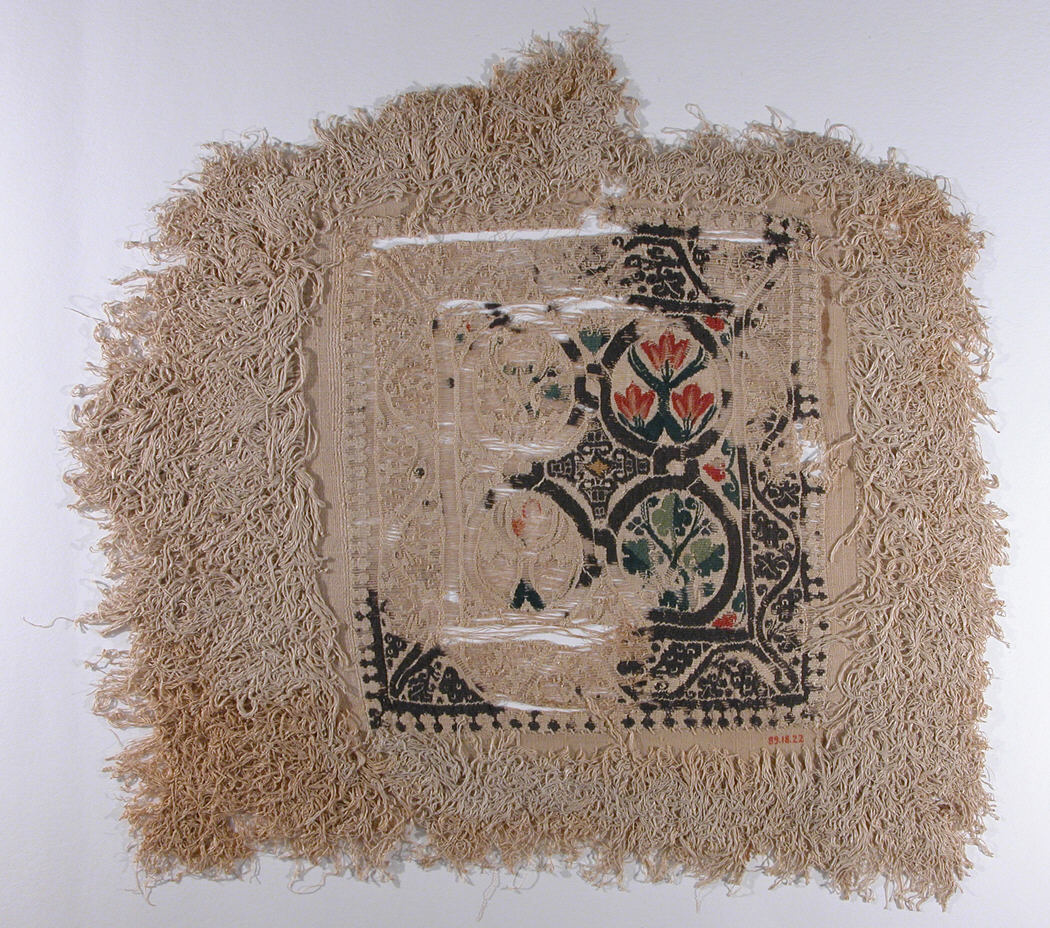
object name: textile fragment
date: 301-500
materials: linen, wool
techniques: weave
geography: egypt